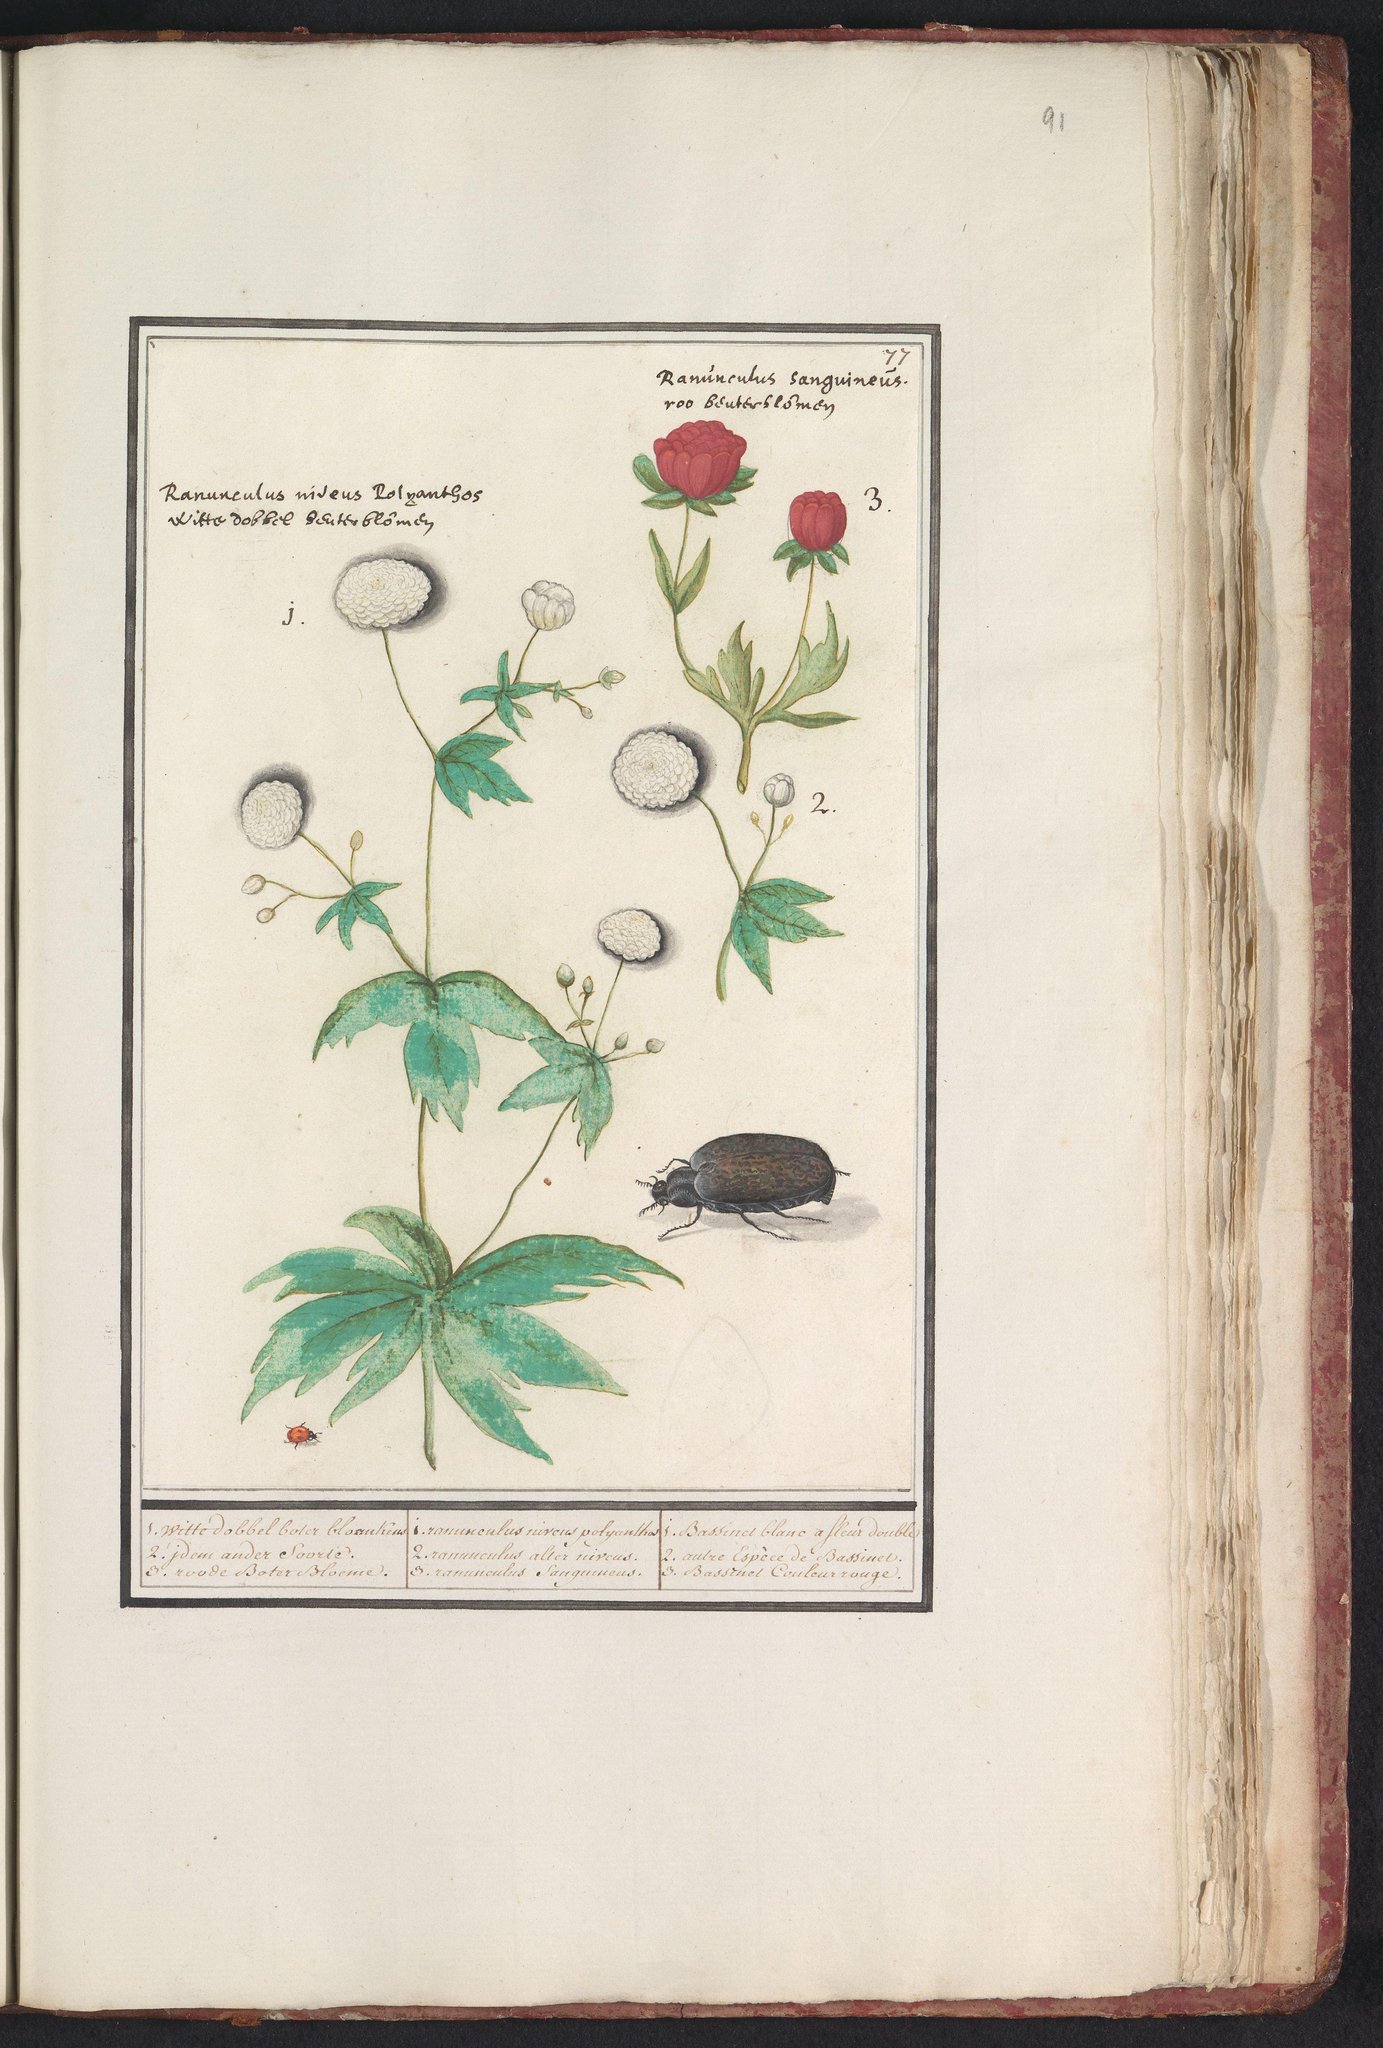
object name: drawing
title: 1. witte dobbel boter bloemkens 2. idem andere soorte. 3. roode Boter Bloeme. / 1, ranunculus niveus polyganthos 2. ranunculus alter niveus. 3. ranunculus Sanguineus. / 1. Bassinet blanc a fleur double 2. autre Espèce de Bassinet. 3. Bassinet Couleur rouge.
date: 1596-1610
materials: chalk, paint, ink, paper, watercolor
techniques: brush, pen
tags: flowers: ranunculus, insects: ladybird, insects: beetle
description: Witte en rode ranonkels. Met een zwarte kever en een lieveheersbeestje. Genummerd rechtsboven: 77. Met de Latijnse en Nederlandse namen. Onderdeel van het eerste album met tekeningen van bloemen en planten. Achtste van twaalf albums met tekeningen van dieren, vogels en planten bekend rond 1600, gemaakt in opdracht van keizer Rudolf II. Met toelichting in Nederlands, Latijn en Frans.